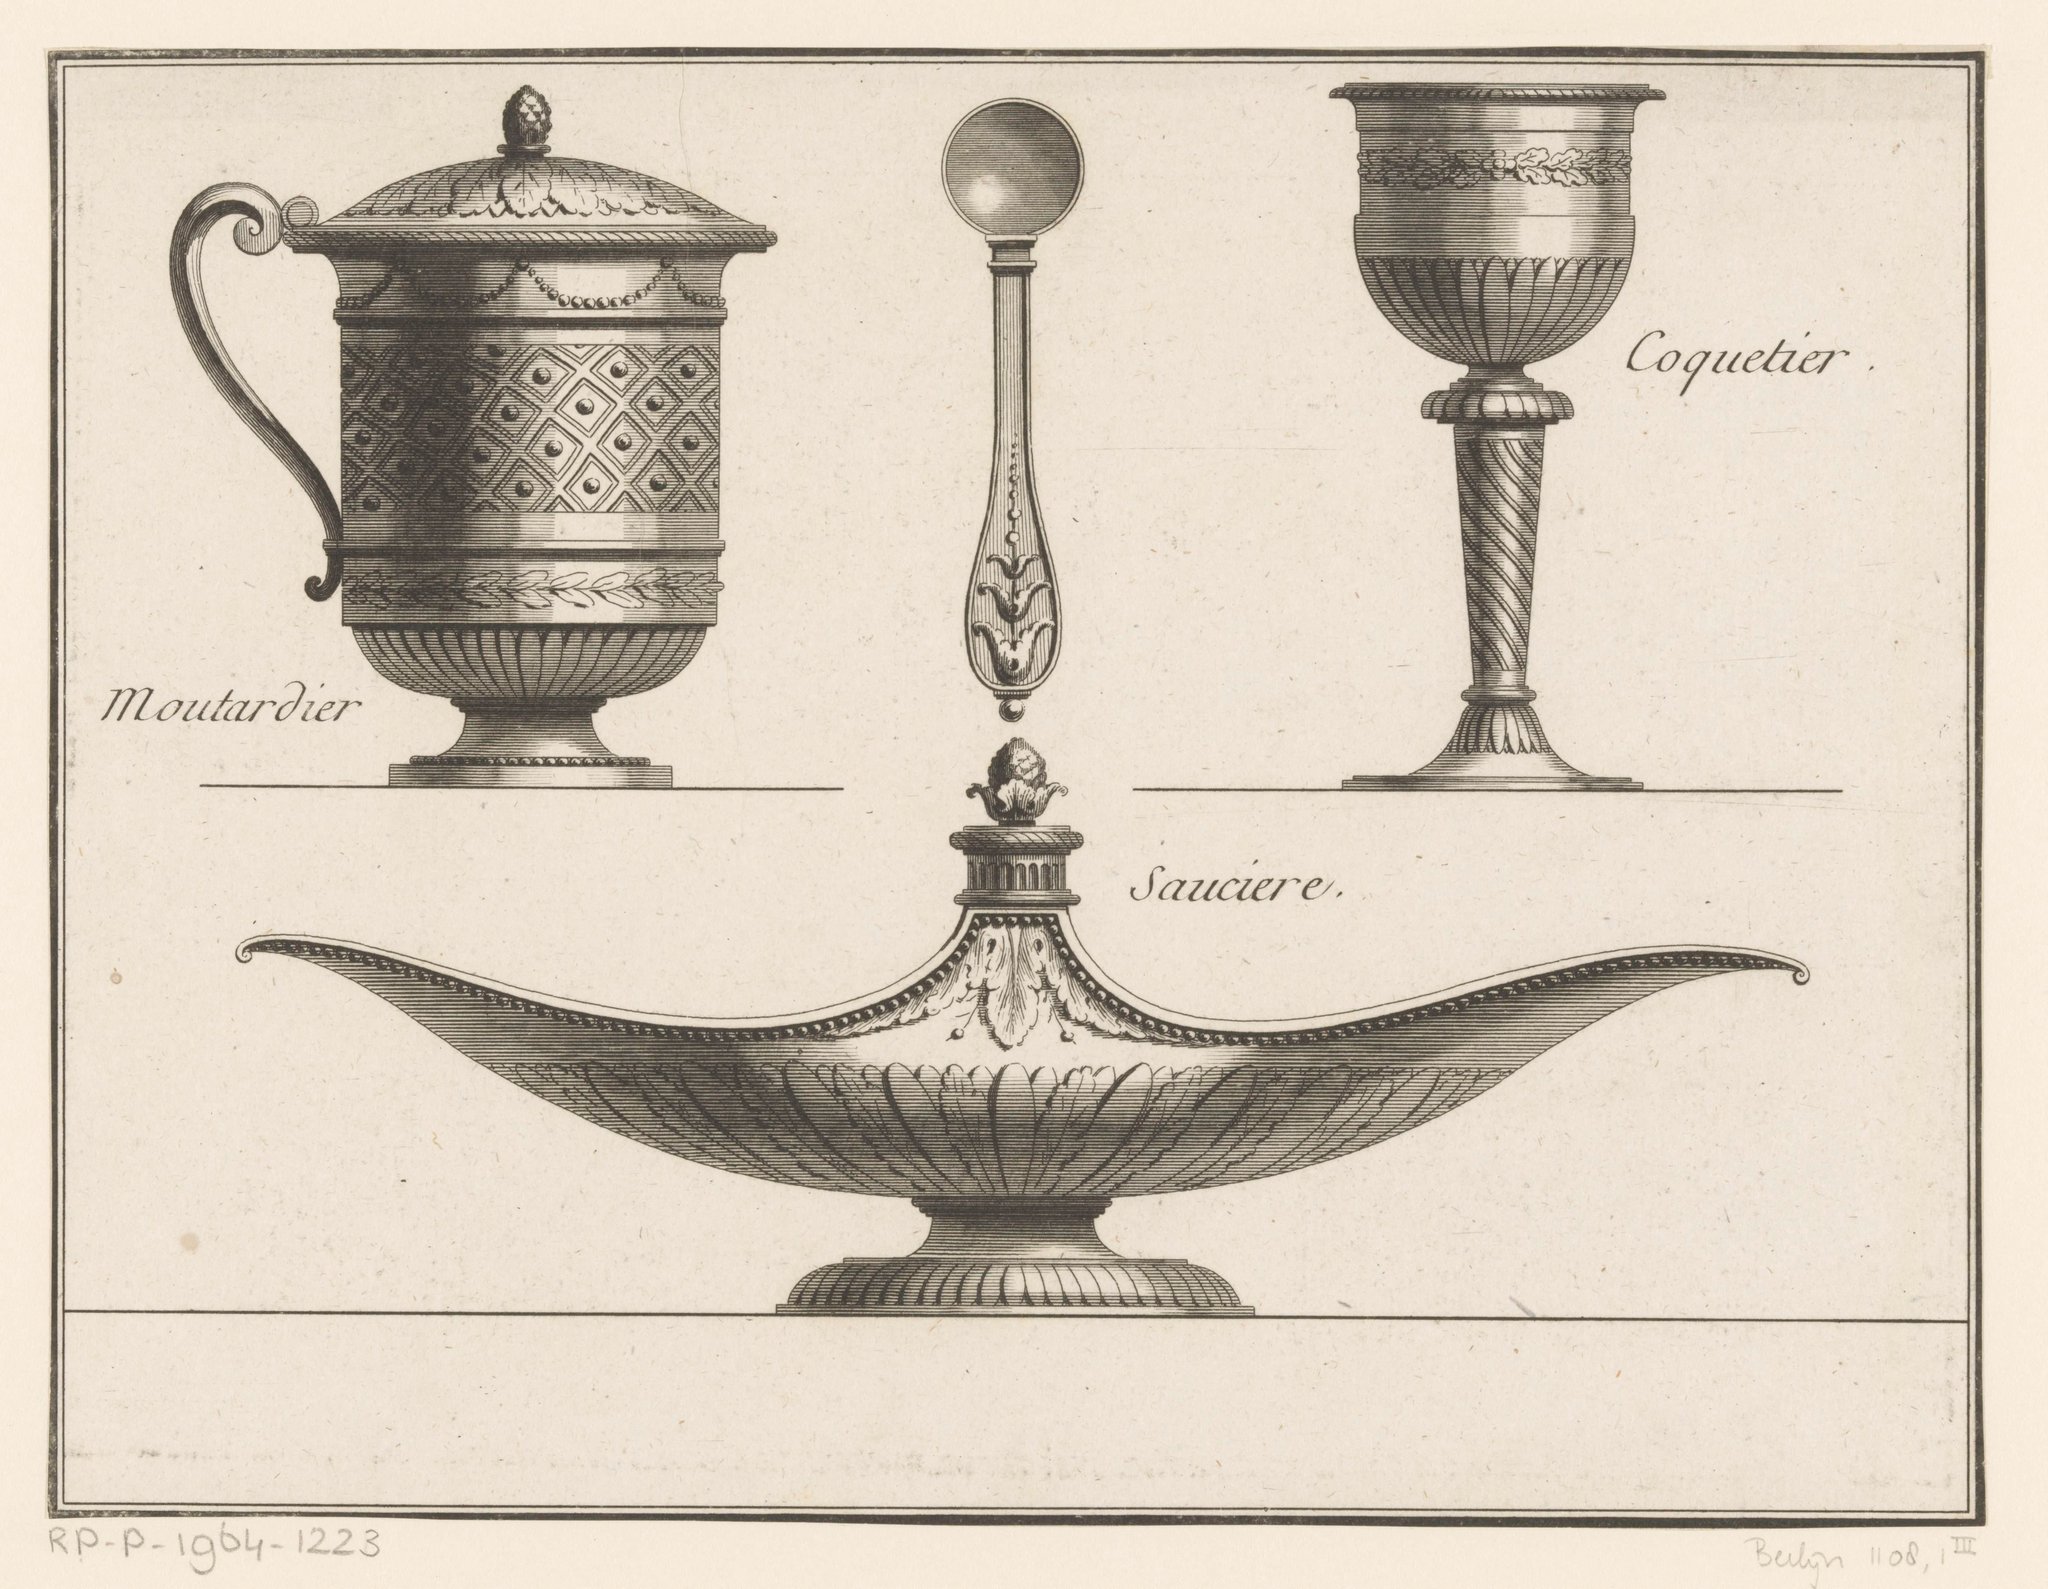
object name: print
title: Edelsmeedkunst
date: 1789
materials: paper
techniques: engraving, etching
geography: paris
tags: mustard, egg-cup, table-ware, sauces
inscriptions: collector's mark: Lugt 2228, collector's mark: Lugt 2760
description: Links boven een geornamenteerde mosterdpot, midden boven een geornamenteerde lepel, rechts een geornamenteerde eierdop op hoge voet en midden onder een geornamenteerde sauskom.